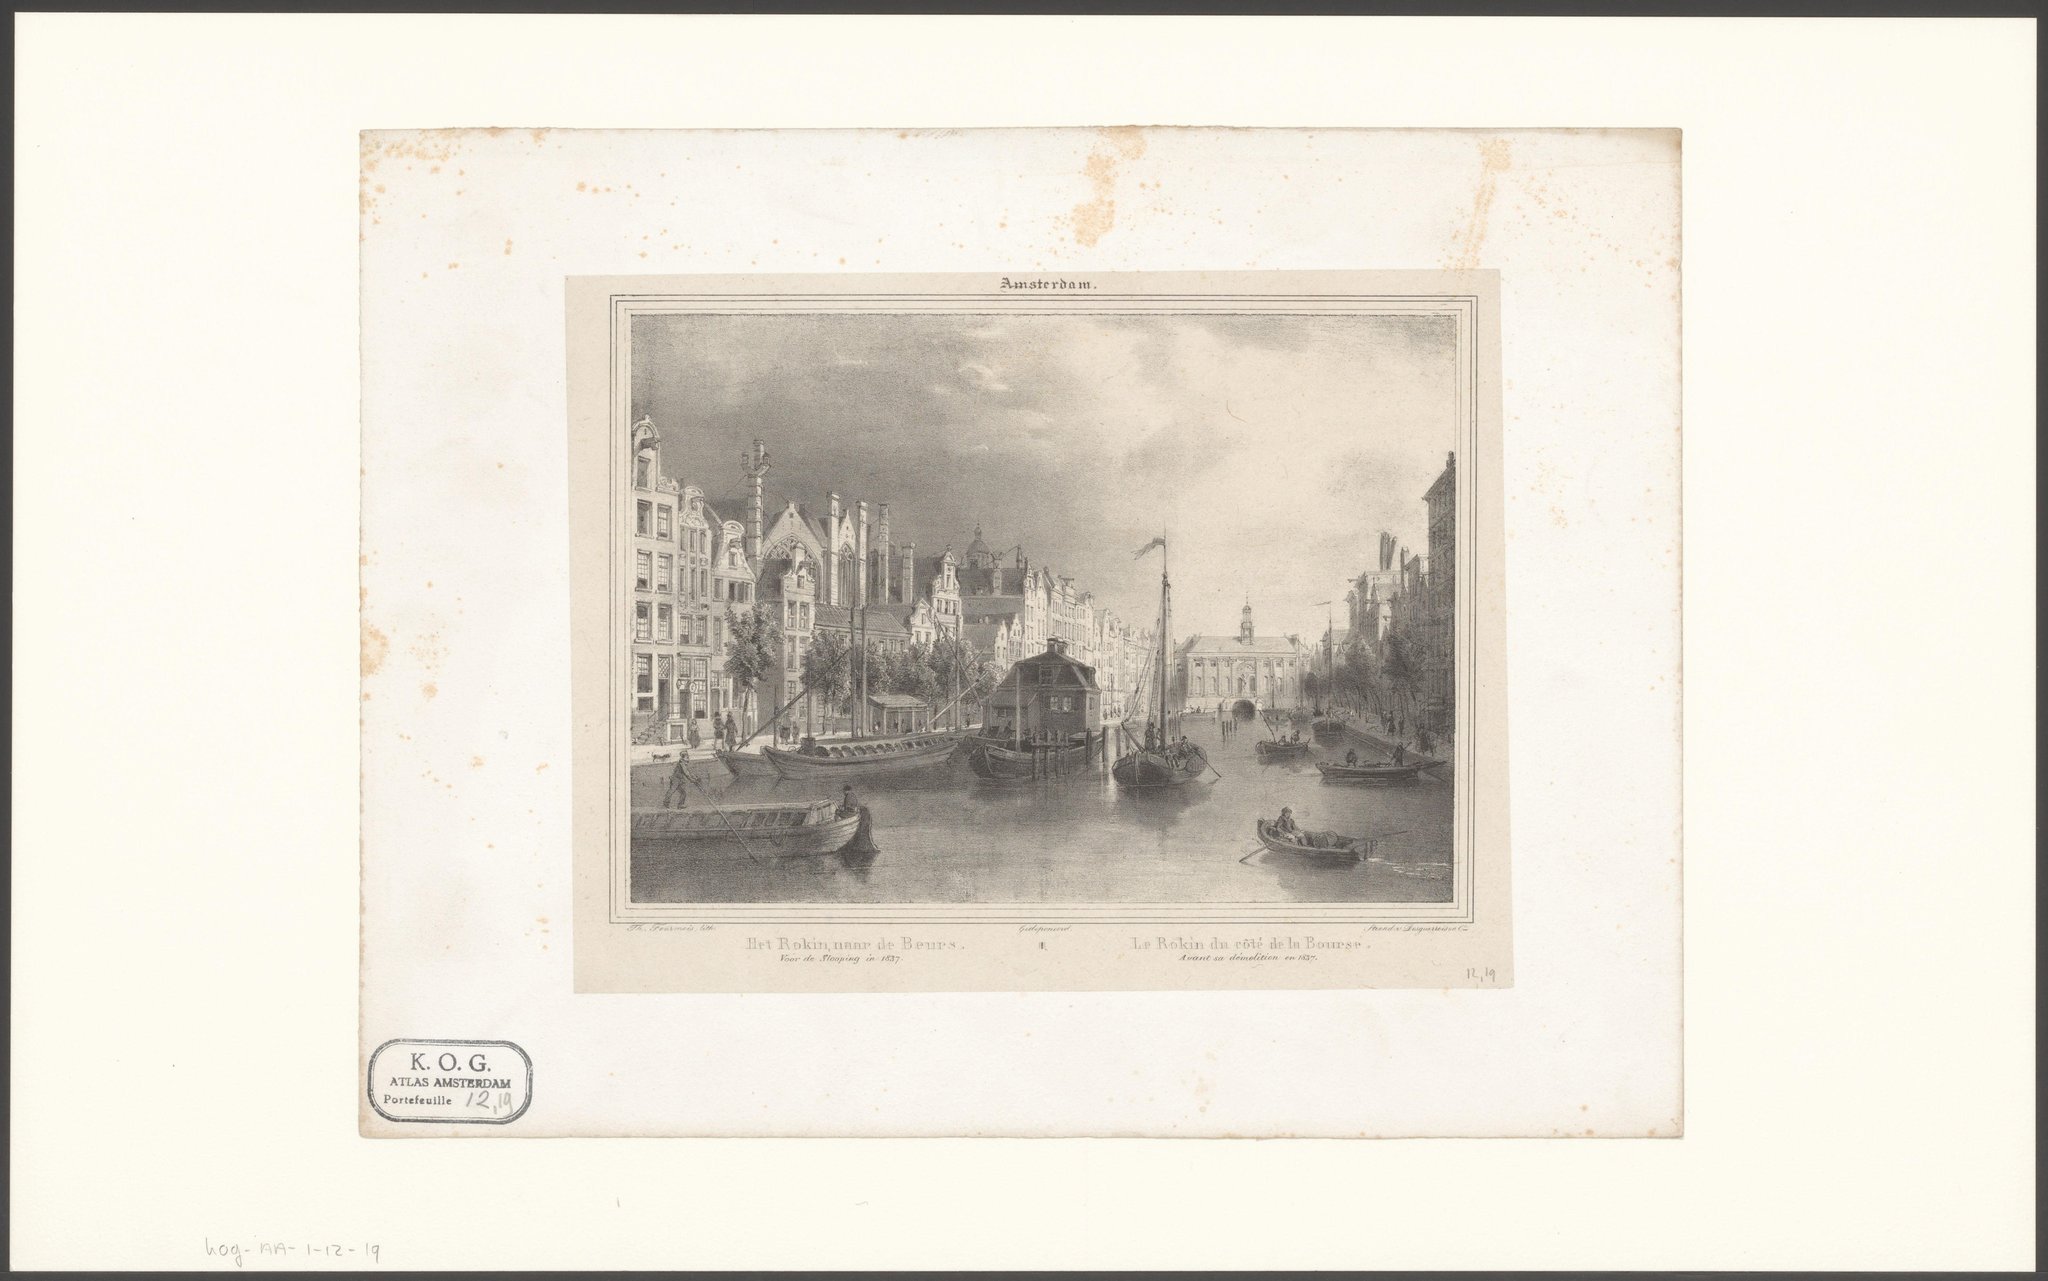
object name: print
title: Gezicht op het Rokin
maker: théodore fourmois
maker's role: print maker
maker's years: 1814-1871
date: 1837-1840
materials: paper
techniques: lithograph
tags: sailing-ship, sailing-boat, city-view in general; 'veduta', canal, street, boat propelled by man or animal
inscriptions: collector's mark: ‘12,19’ Lugt 1641b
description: Prent behoort mogelijk tot een serie met gezichten op Amsterdam, Rotterdam, Haarlem, Den Haag en Huis te Brederode. Desguerrois heeft hier midden jaren dertig opdracht voor gegeven aan onder meer Lauters, Fourmois en Clerman.